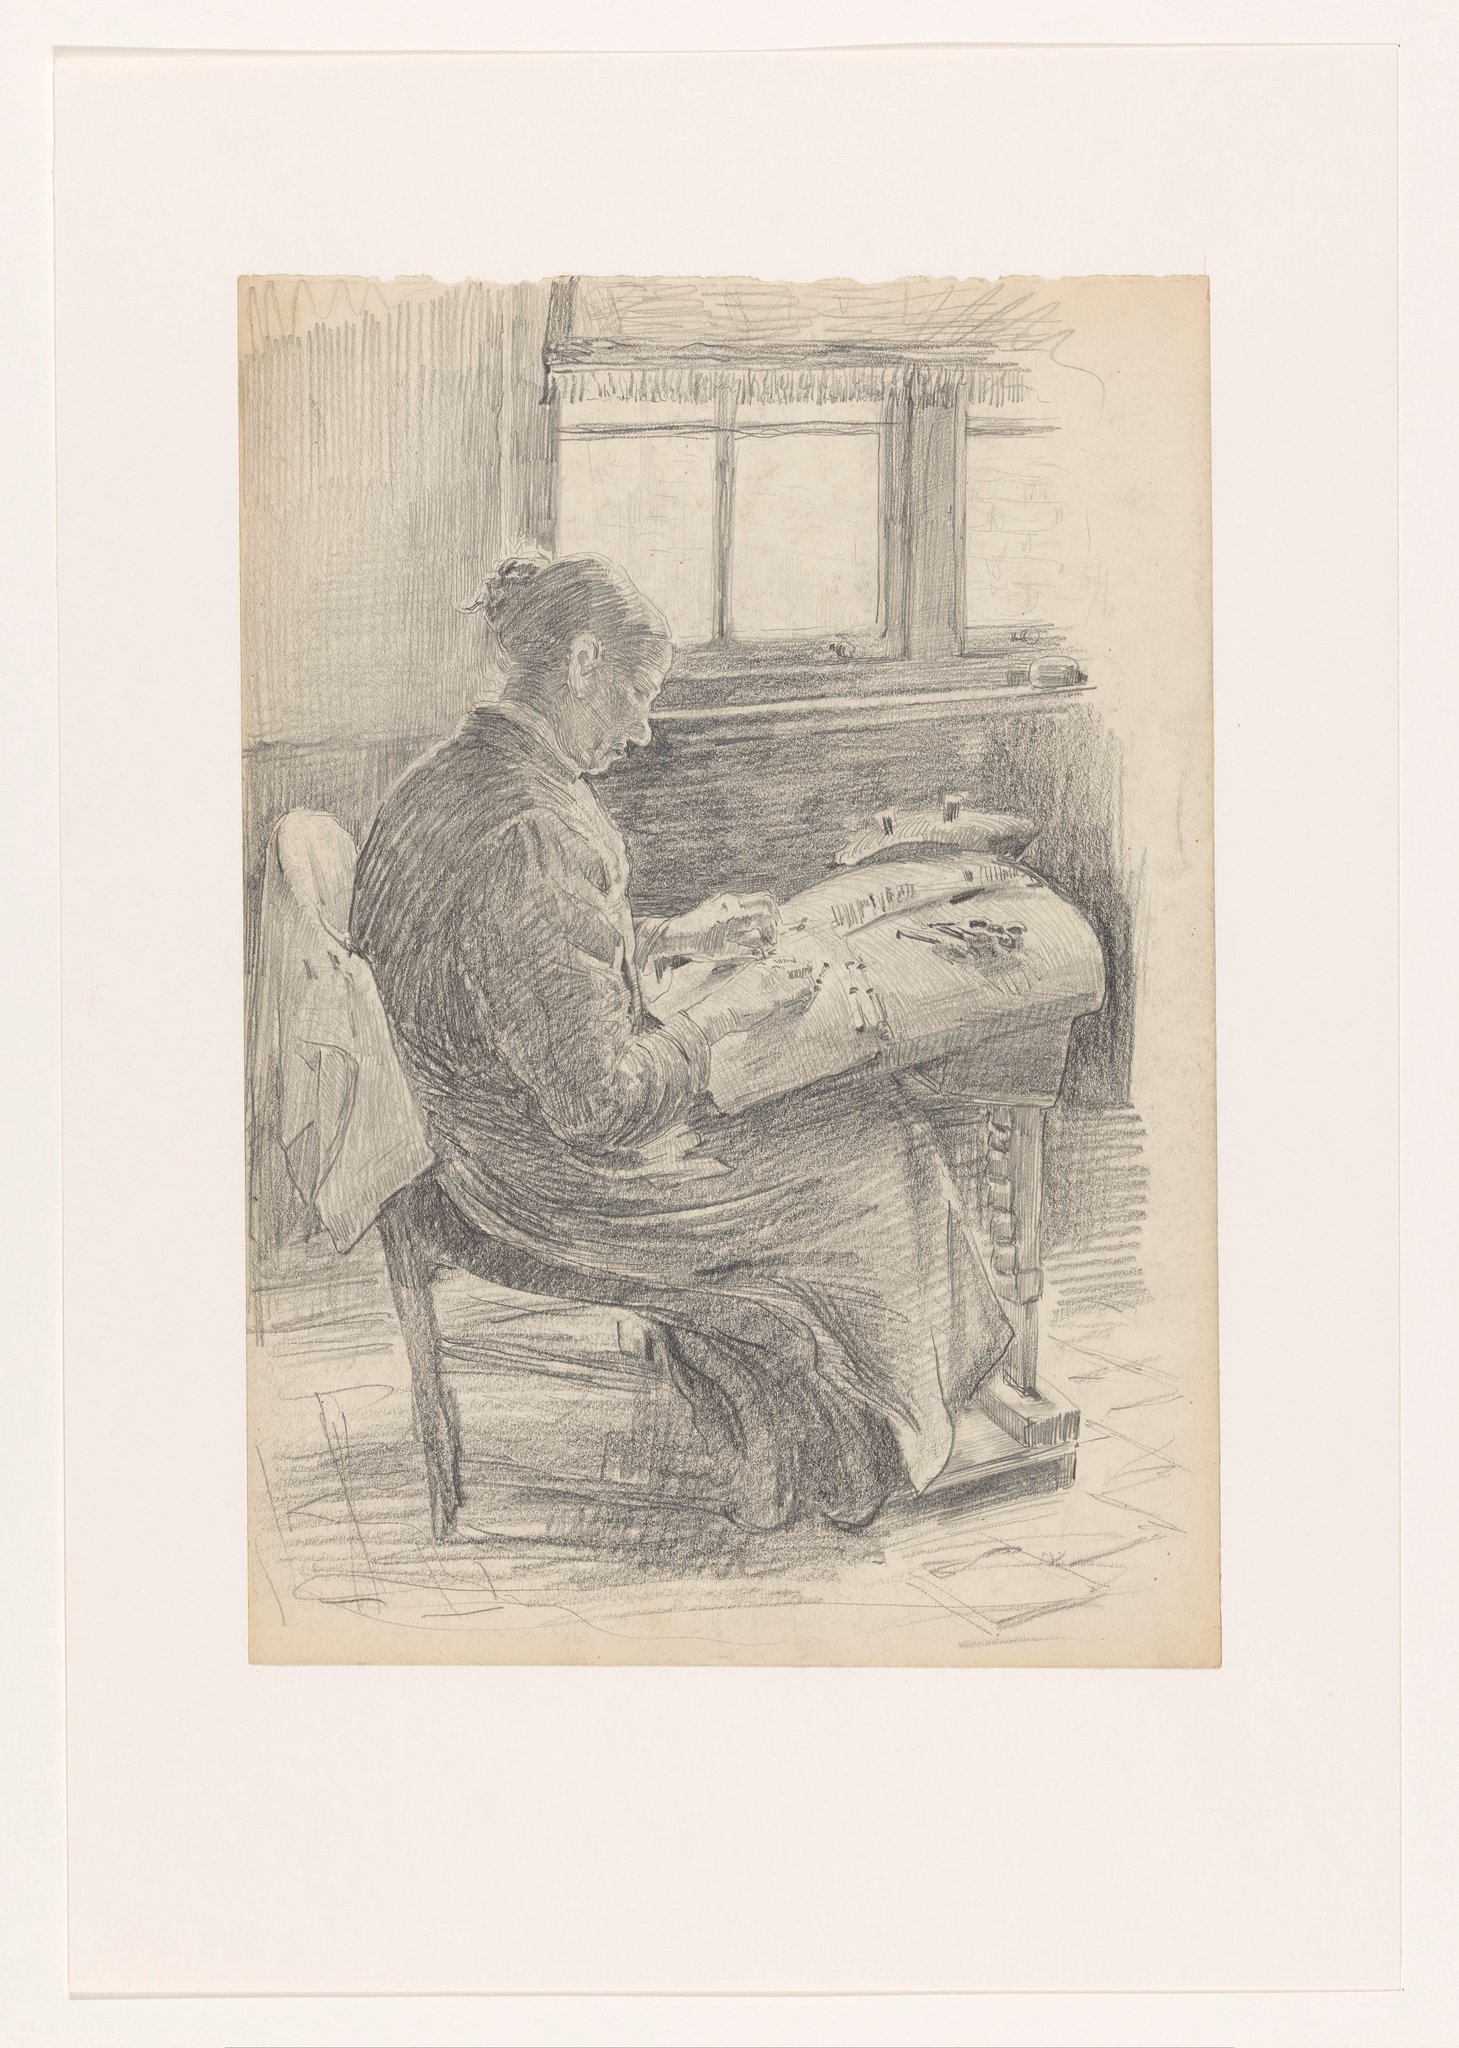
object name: drawing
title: Kantklossende vrouw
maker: martinus van regteren altena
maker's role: painter, print maker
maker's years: 1866-1908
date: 1906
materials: paper, pencil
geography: bruges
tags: lace-making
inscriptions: collector's mark: Lugt 2228